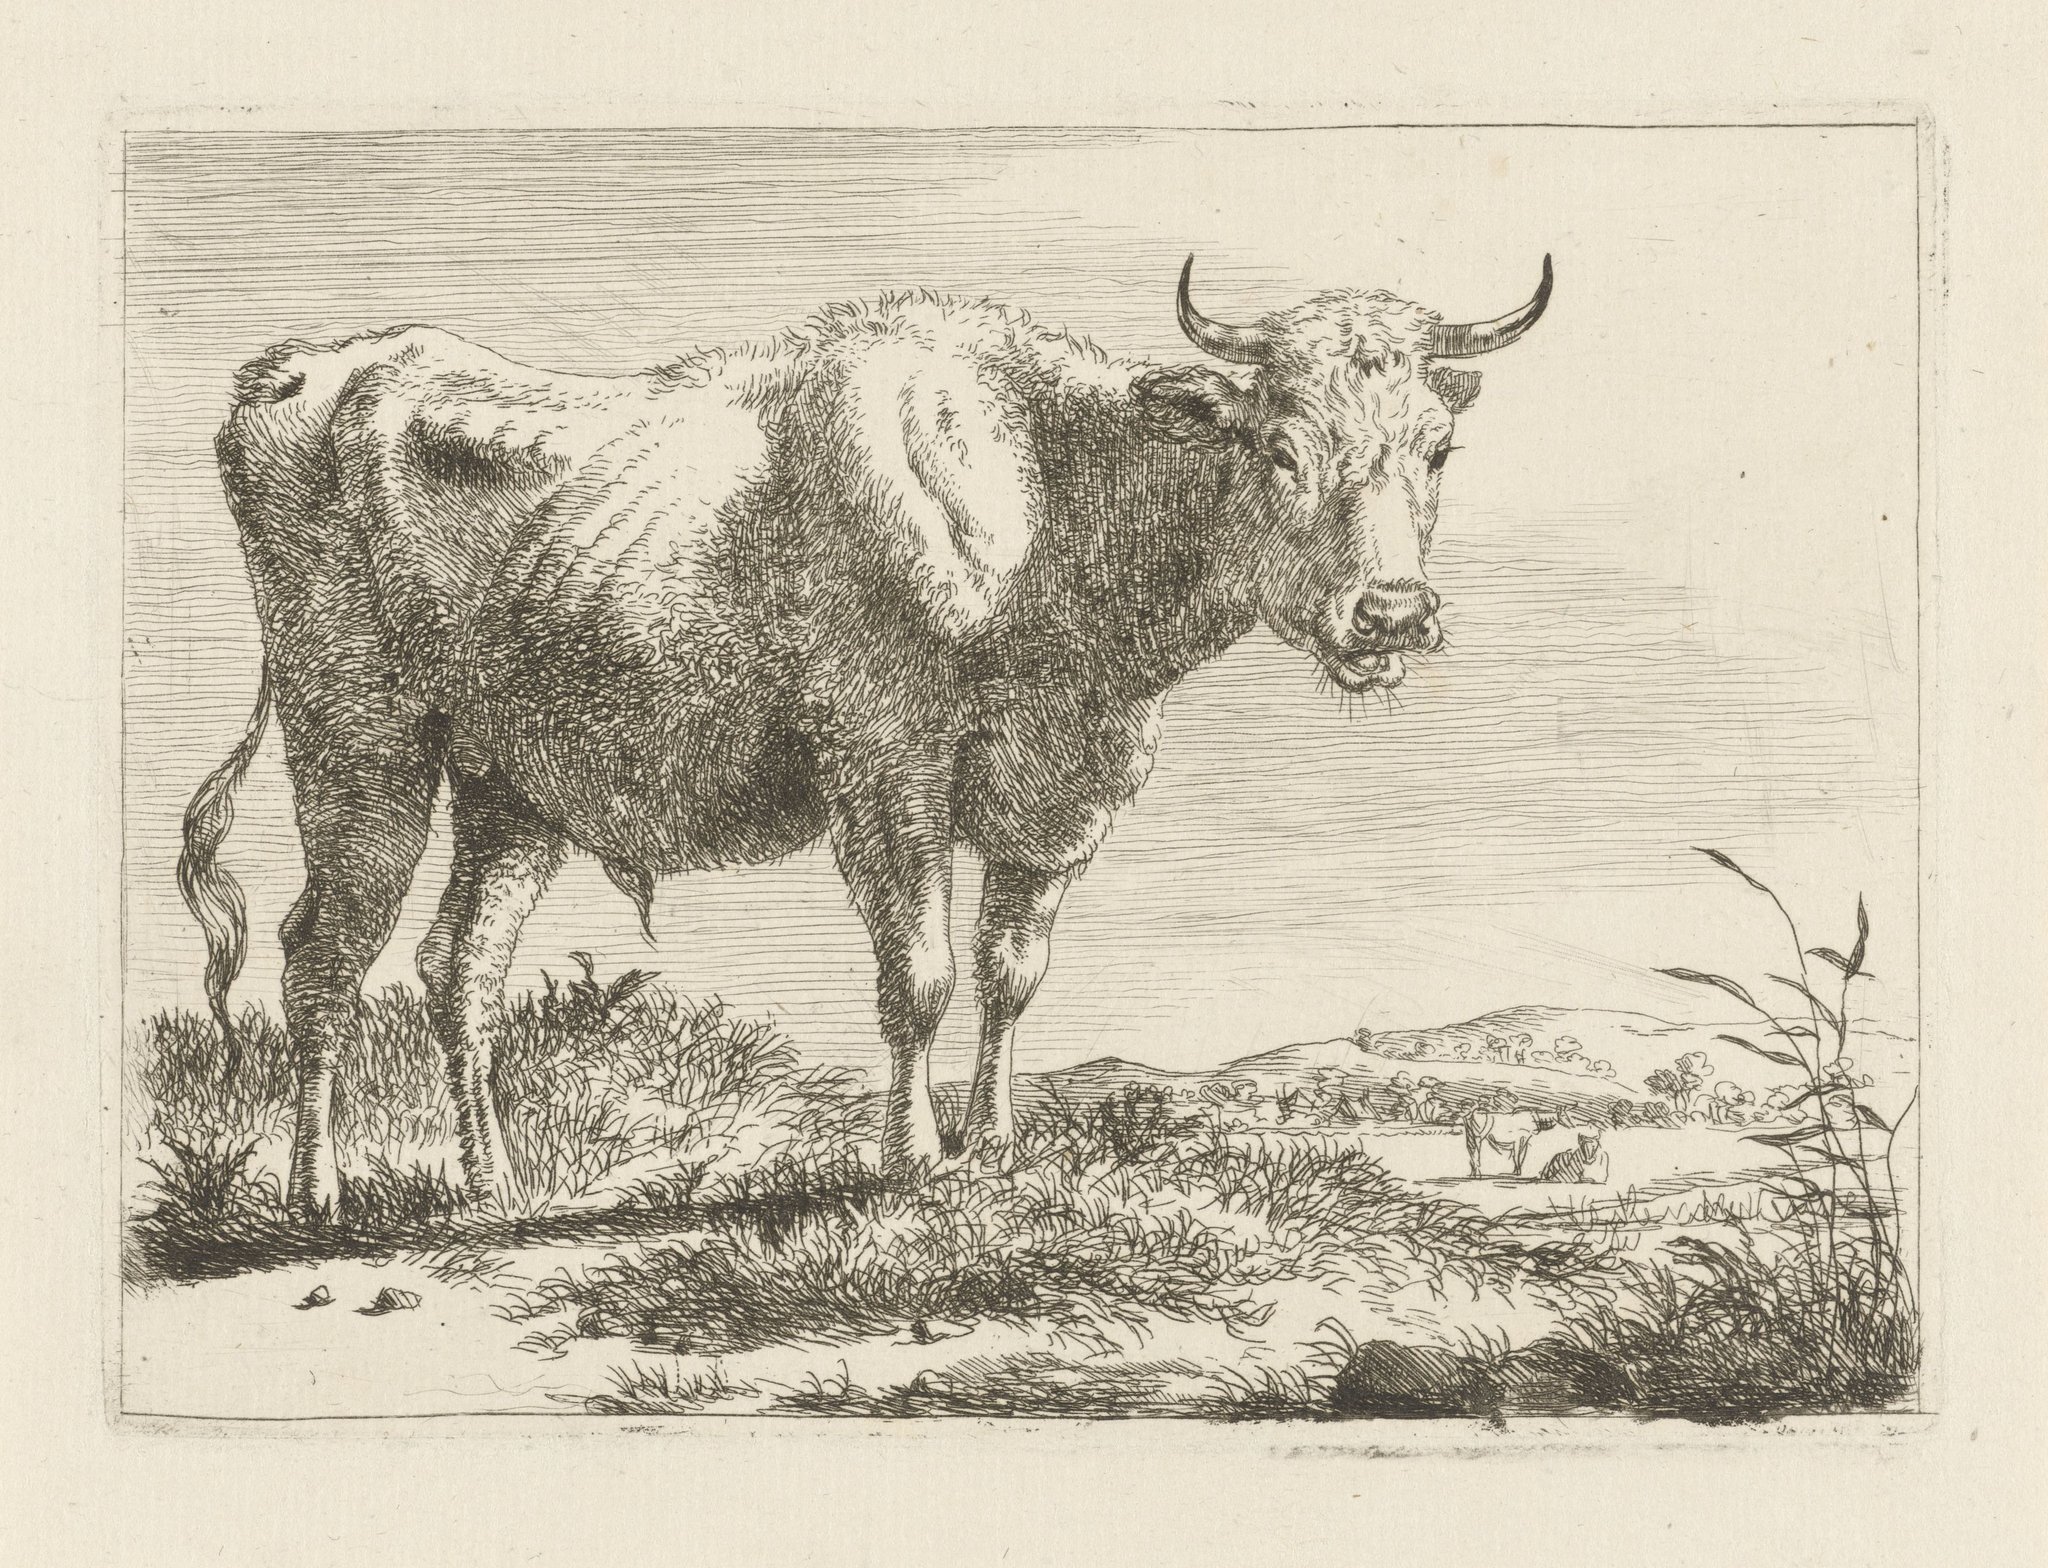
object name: print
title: Staande stier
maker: pieter gerardus van os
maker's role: draughtsman, painter, print maker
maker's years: 1776-1839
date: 1798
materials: paper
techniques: etching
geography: netherlands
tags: bull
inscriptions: collector's mark: Lugt 2228